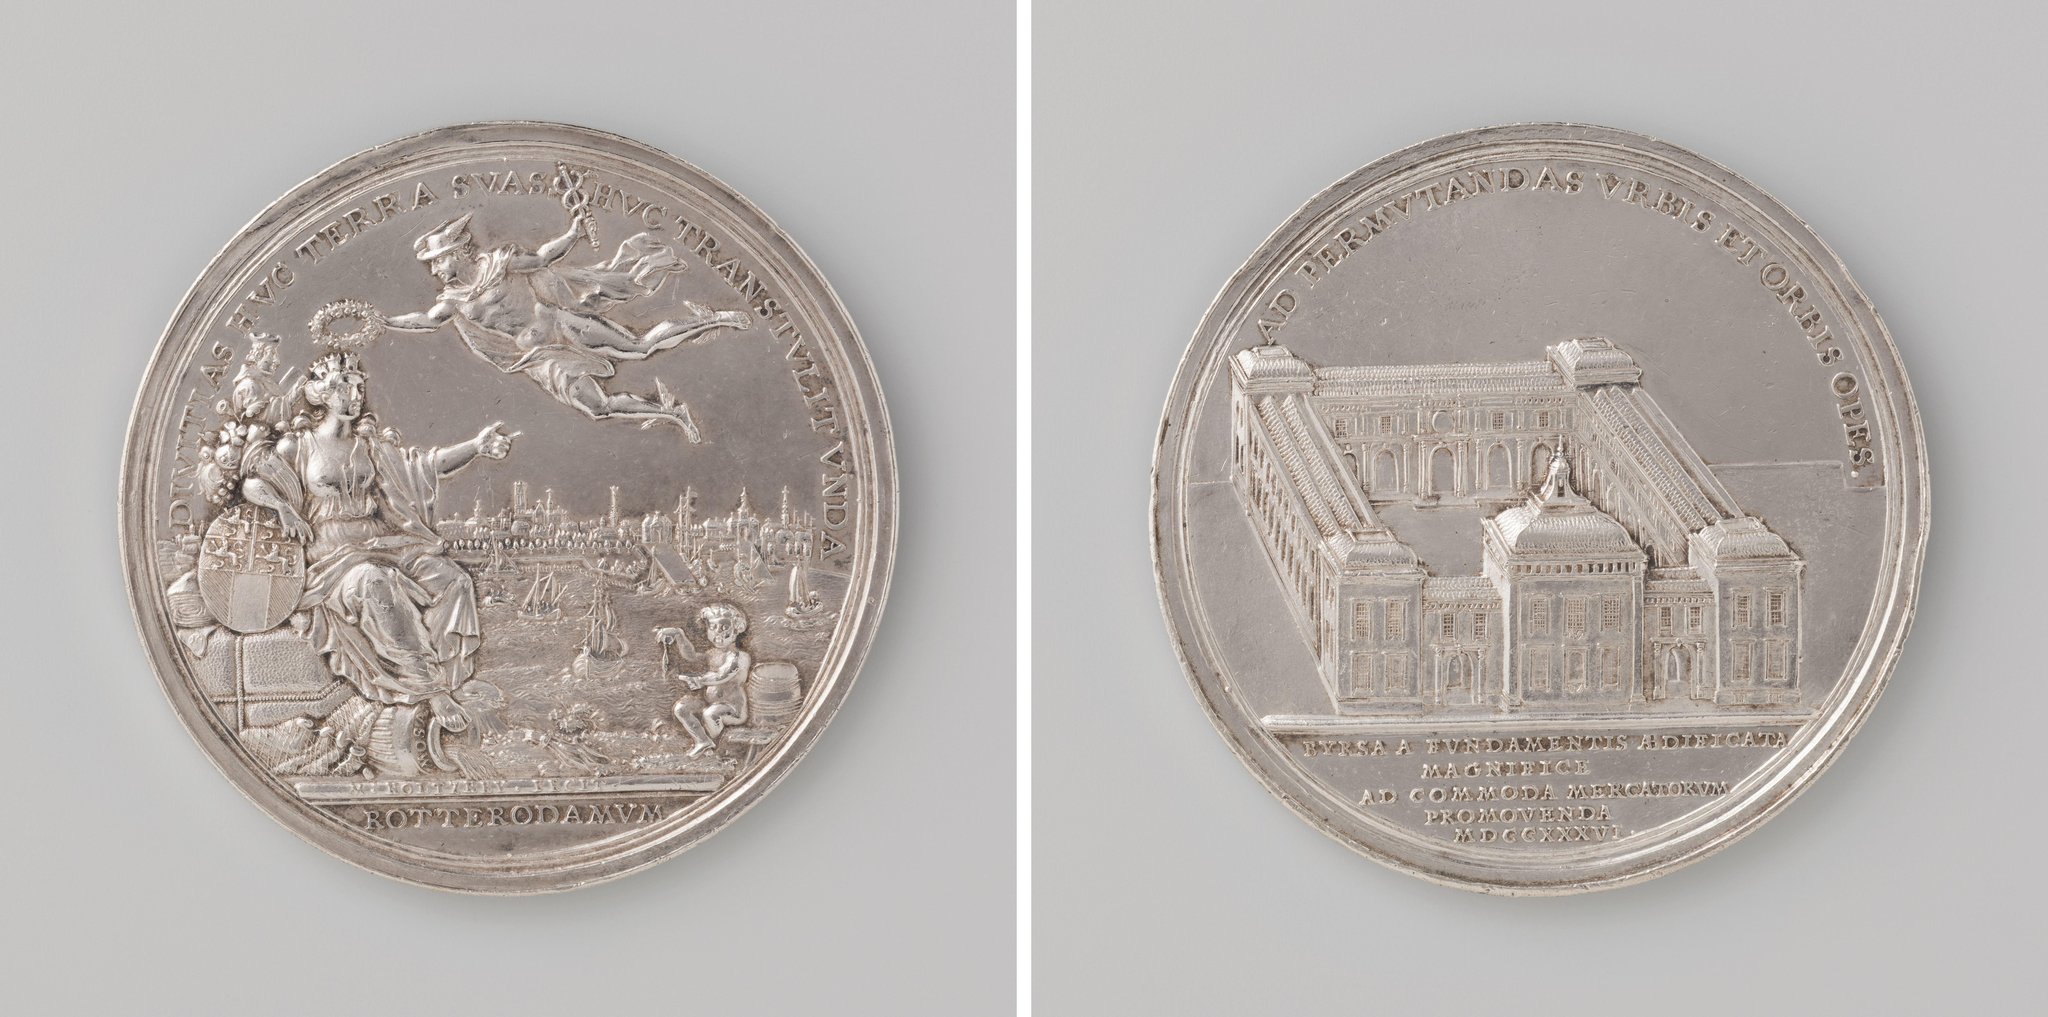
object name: history medal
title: Stichting van de beurs te Rotterdam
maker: martinus holtzhey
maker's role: medailleur, muntmaker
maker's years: 1697-1764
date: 1736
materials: silver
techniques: striking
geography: amsterdam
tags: stock exchange, stock-market, rotterdam